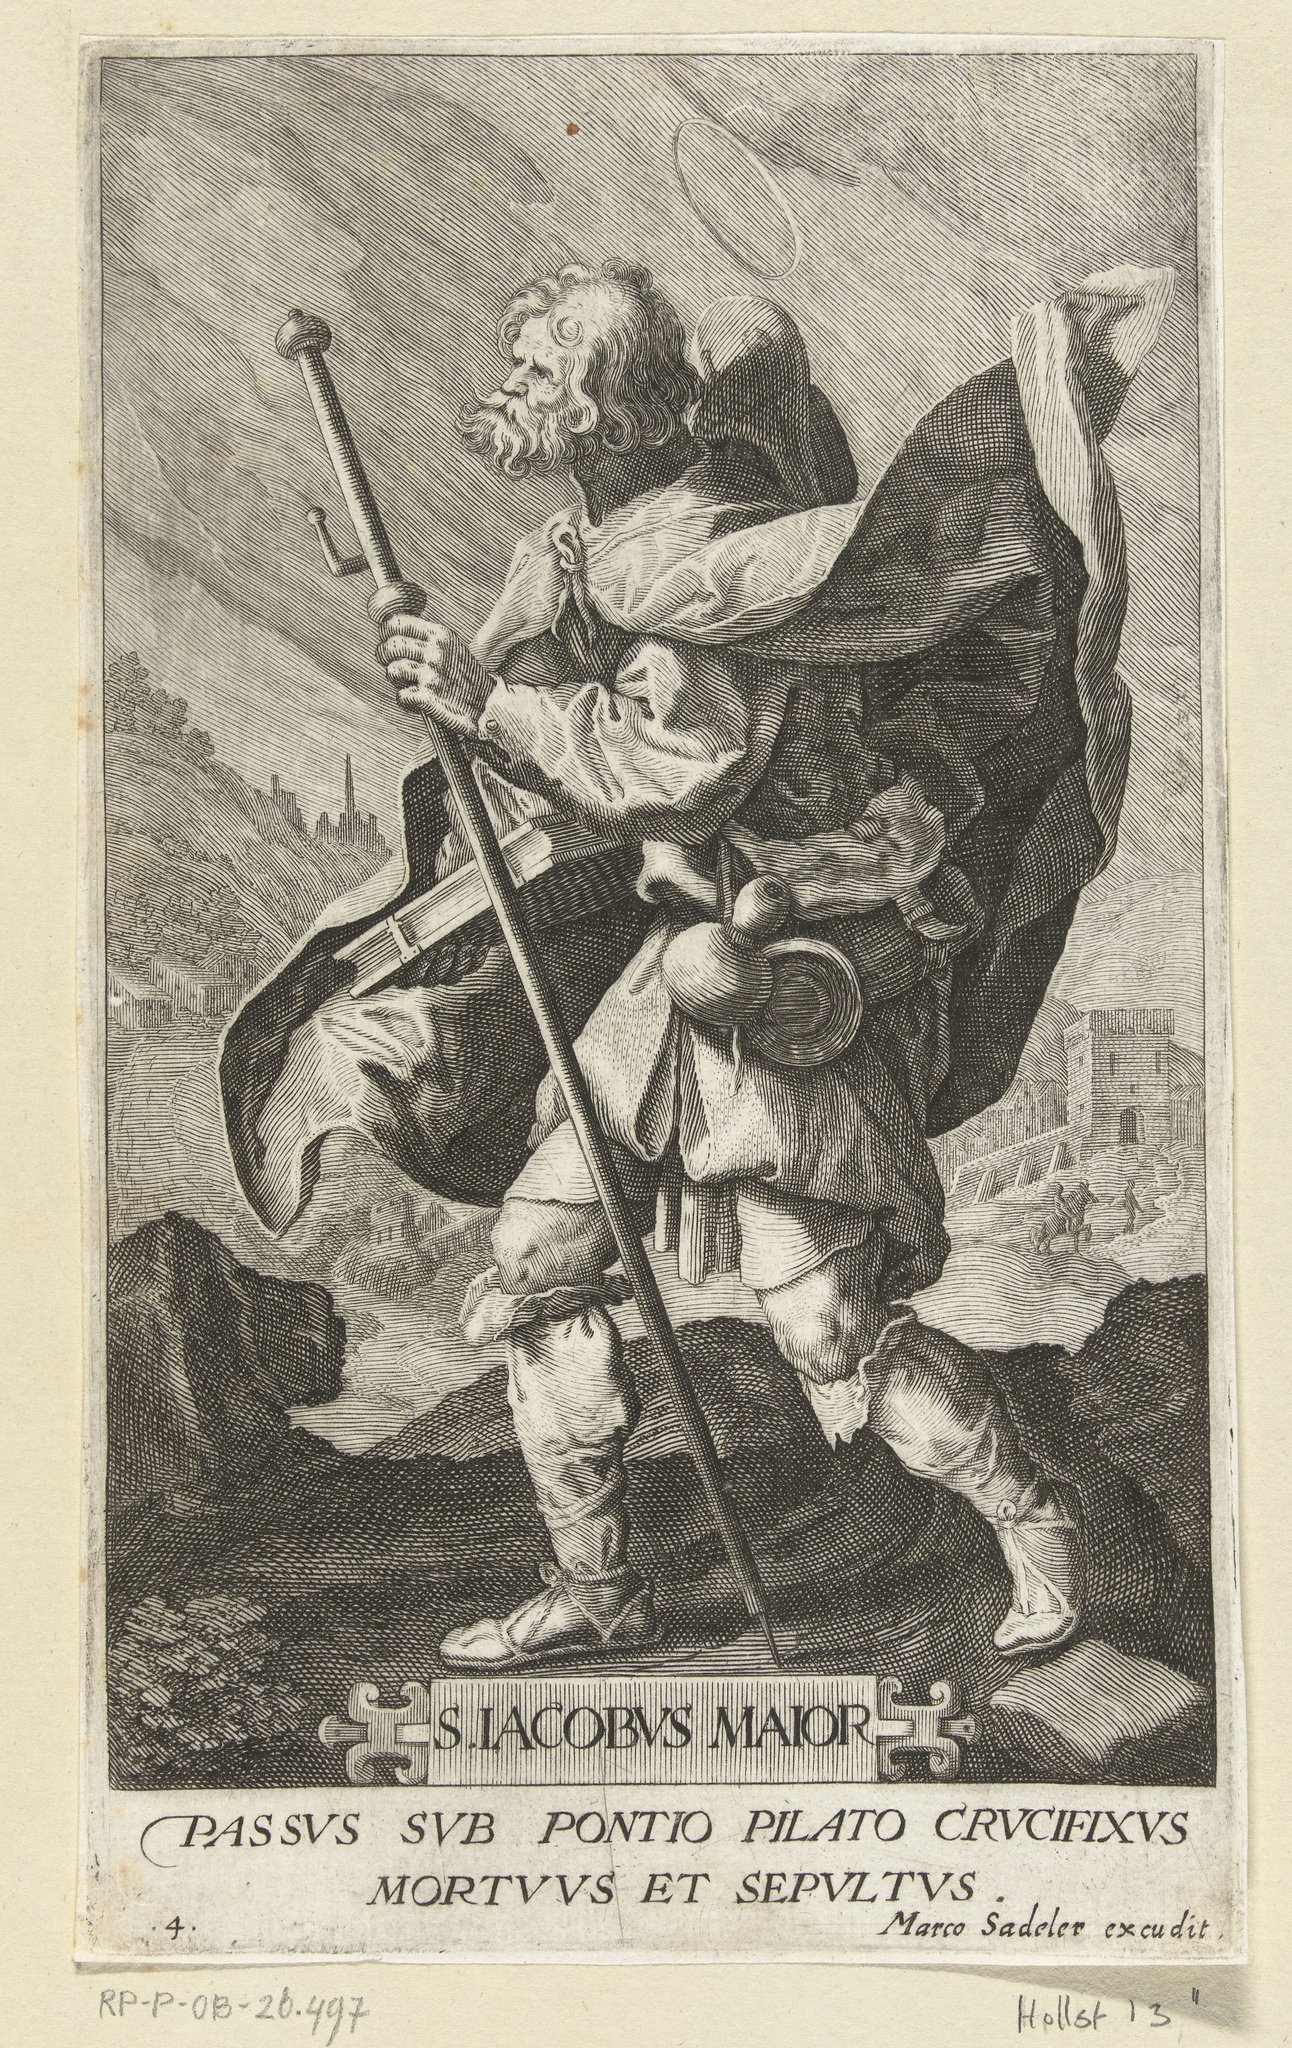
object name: print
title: S. Iacobvs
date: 1591-1629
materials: paper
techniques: engraving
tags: the apostle james the great; possible attributes: book, pilgrim's cloak, hat, shell, staff, and wallet, scroll, sword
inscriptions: collector's mark: Lugt 240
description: Apostel Jakobus de Meerdere (Jacobus Maior) als pelgrim met pelgrimsstaf en pelgrimskruik. Onder de voorstelling staat een Latijnse regel uit de apostolische geloofsbelijdenis.